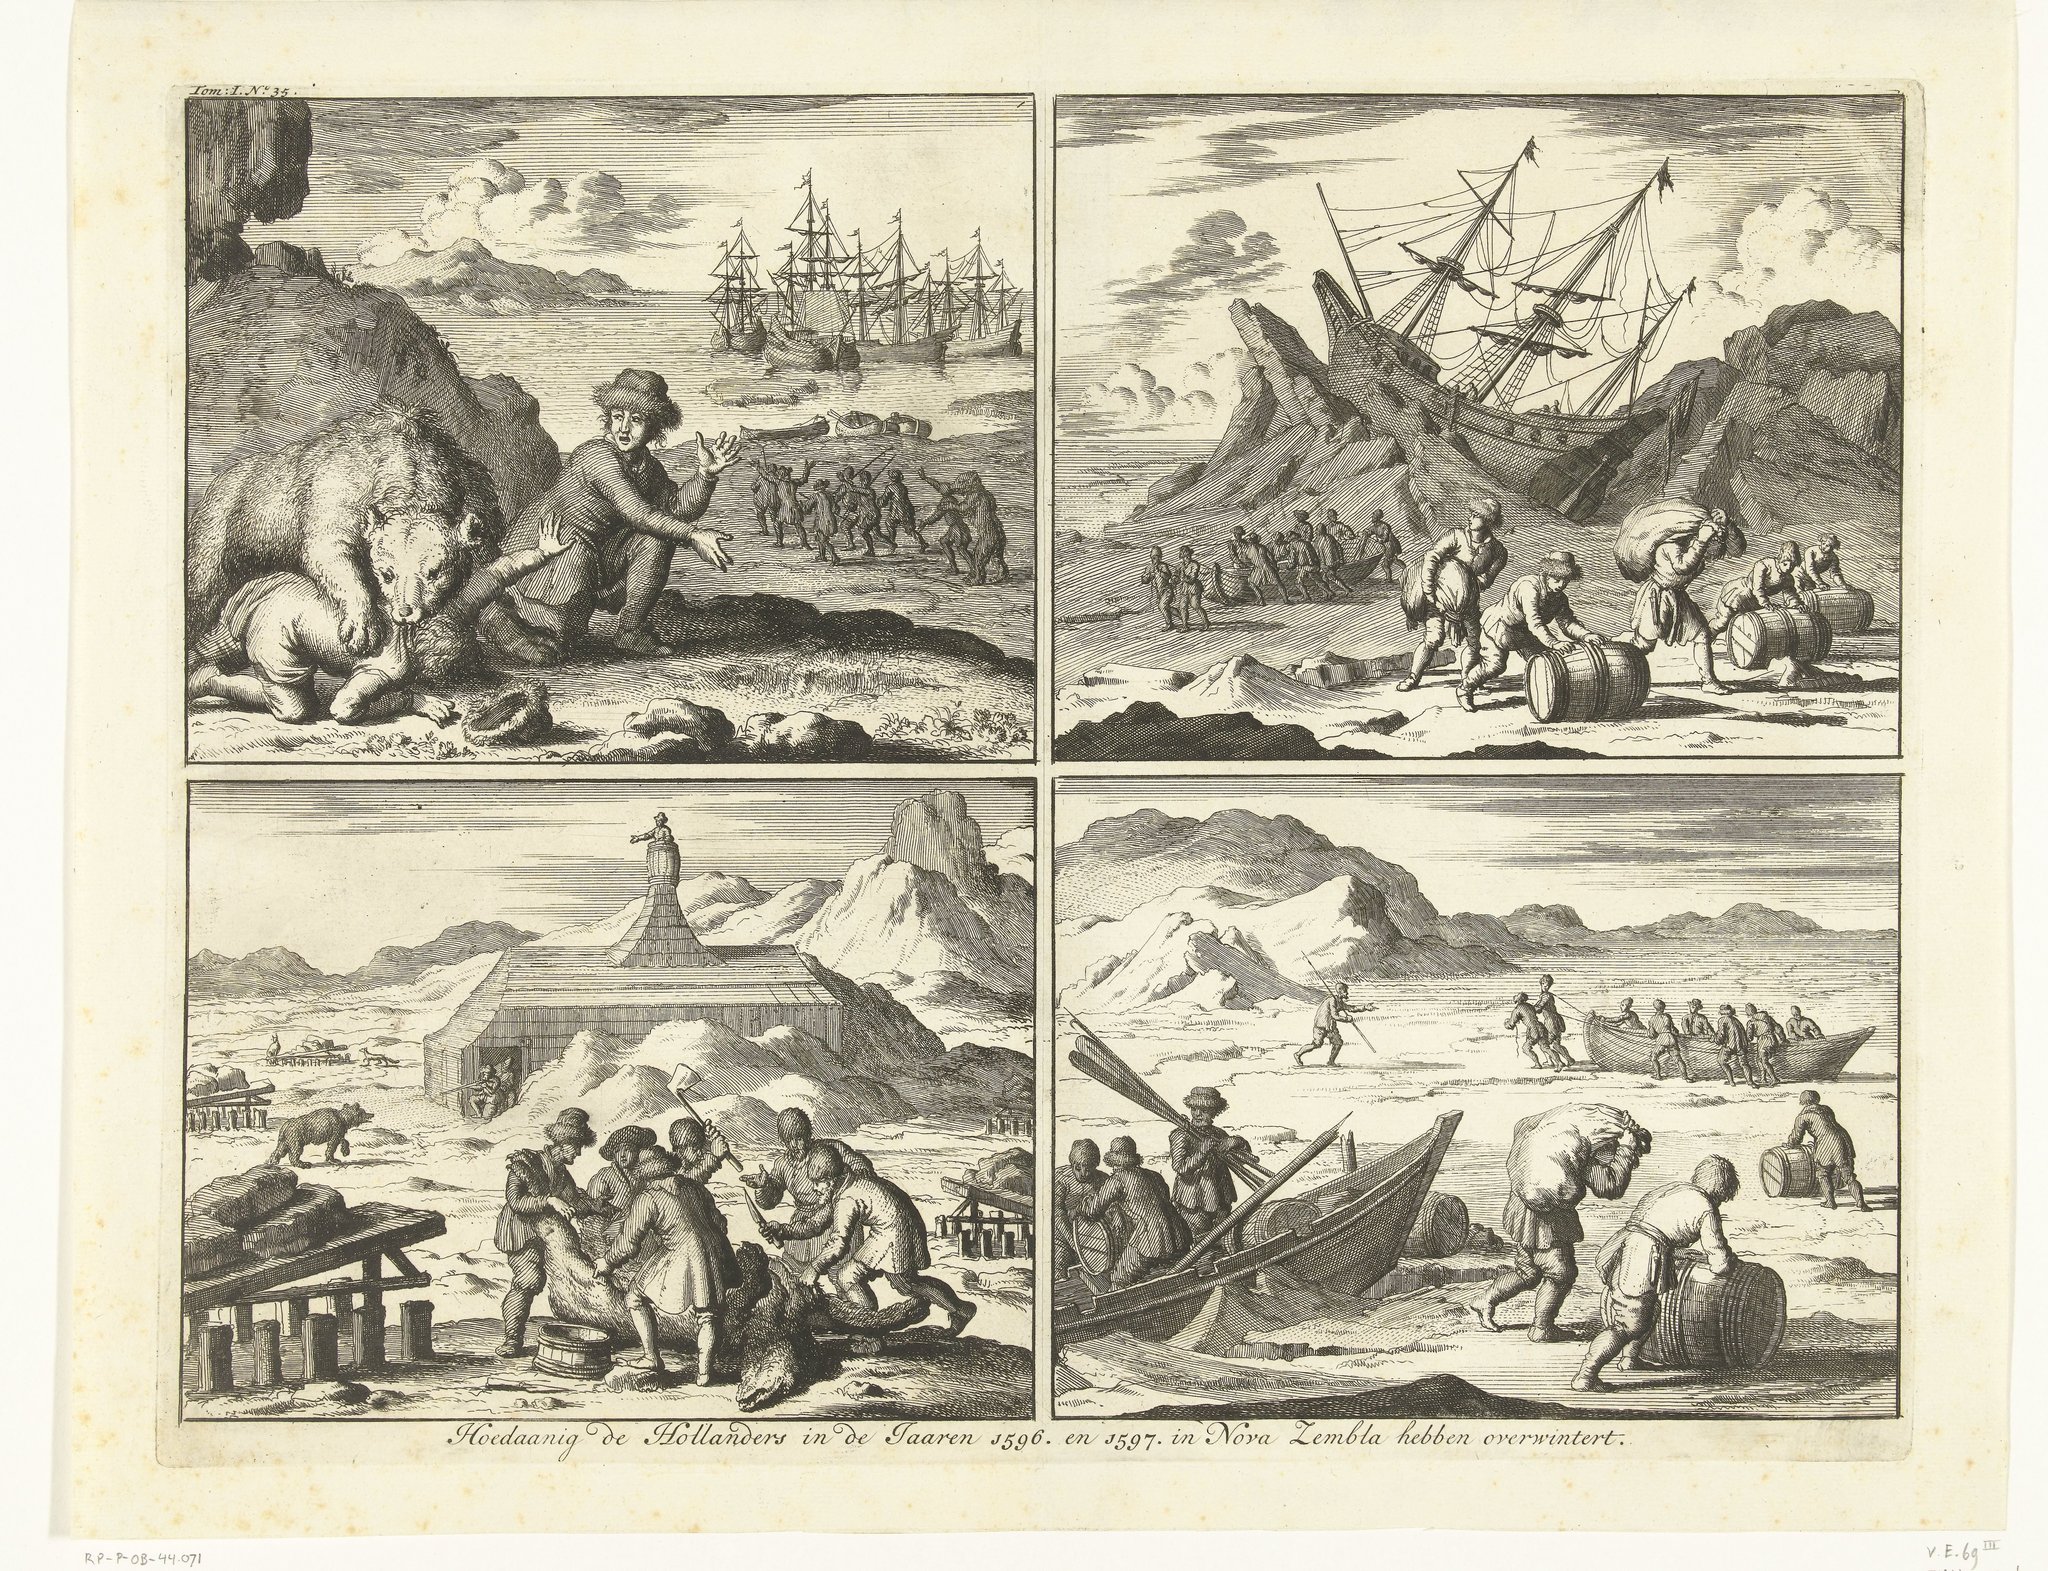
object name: history print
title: Overwintering op Nova Zembla, 1596-1597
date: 1682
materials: paper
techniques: etching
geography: northern netherlands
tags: willem barendsz., amsterdam, jacob van heemskerck, beasts of prey, predatory animals: polar bear, island (in polar regions), icefield, exploration, expedition, voyage of discovery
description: Gebruikt als illustratie in: J. le Clerc, Geschiedenissen der Vereenigde Nederlanden, sedert den aanvang van die Republyk tot op den Vrede van Utrecht in 't jaar 1713 en het Tractaat van Barriere in 't jaar 1715 gesloten, Z. Chatelain, Amsterdam 1730, 3 delen, Tom. I. No. 35.